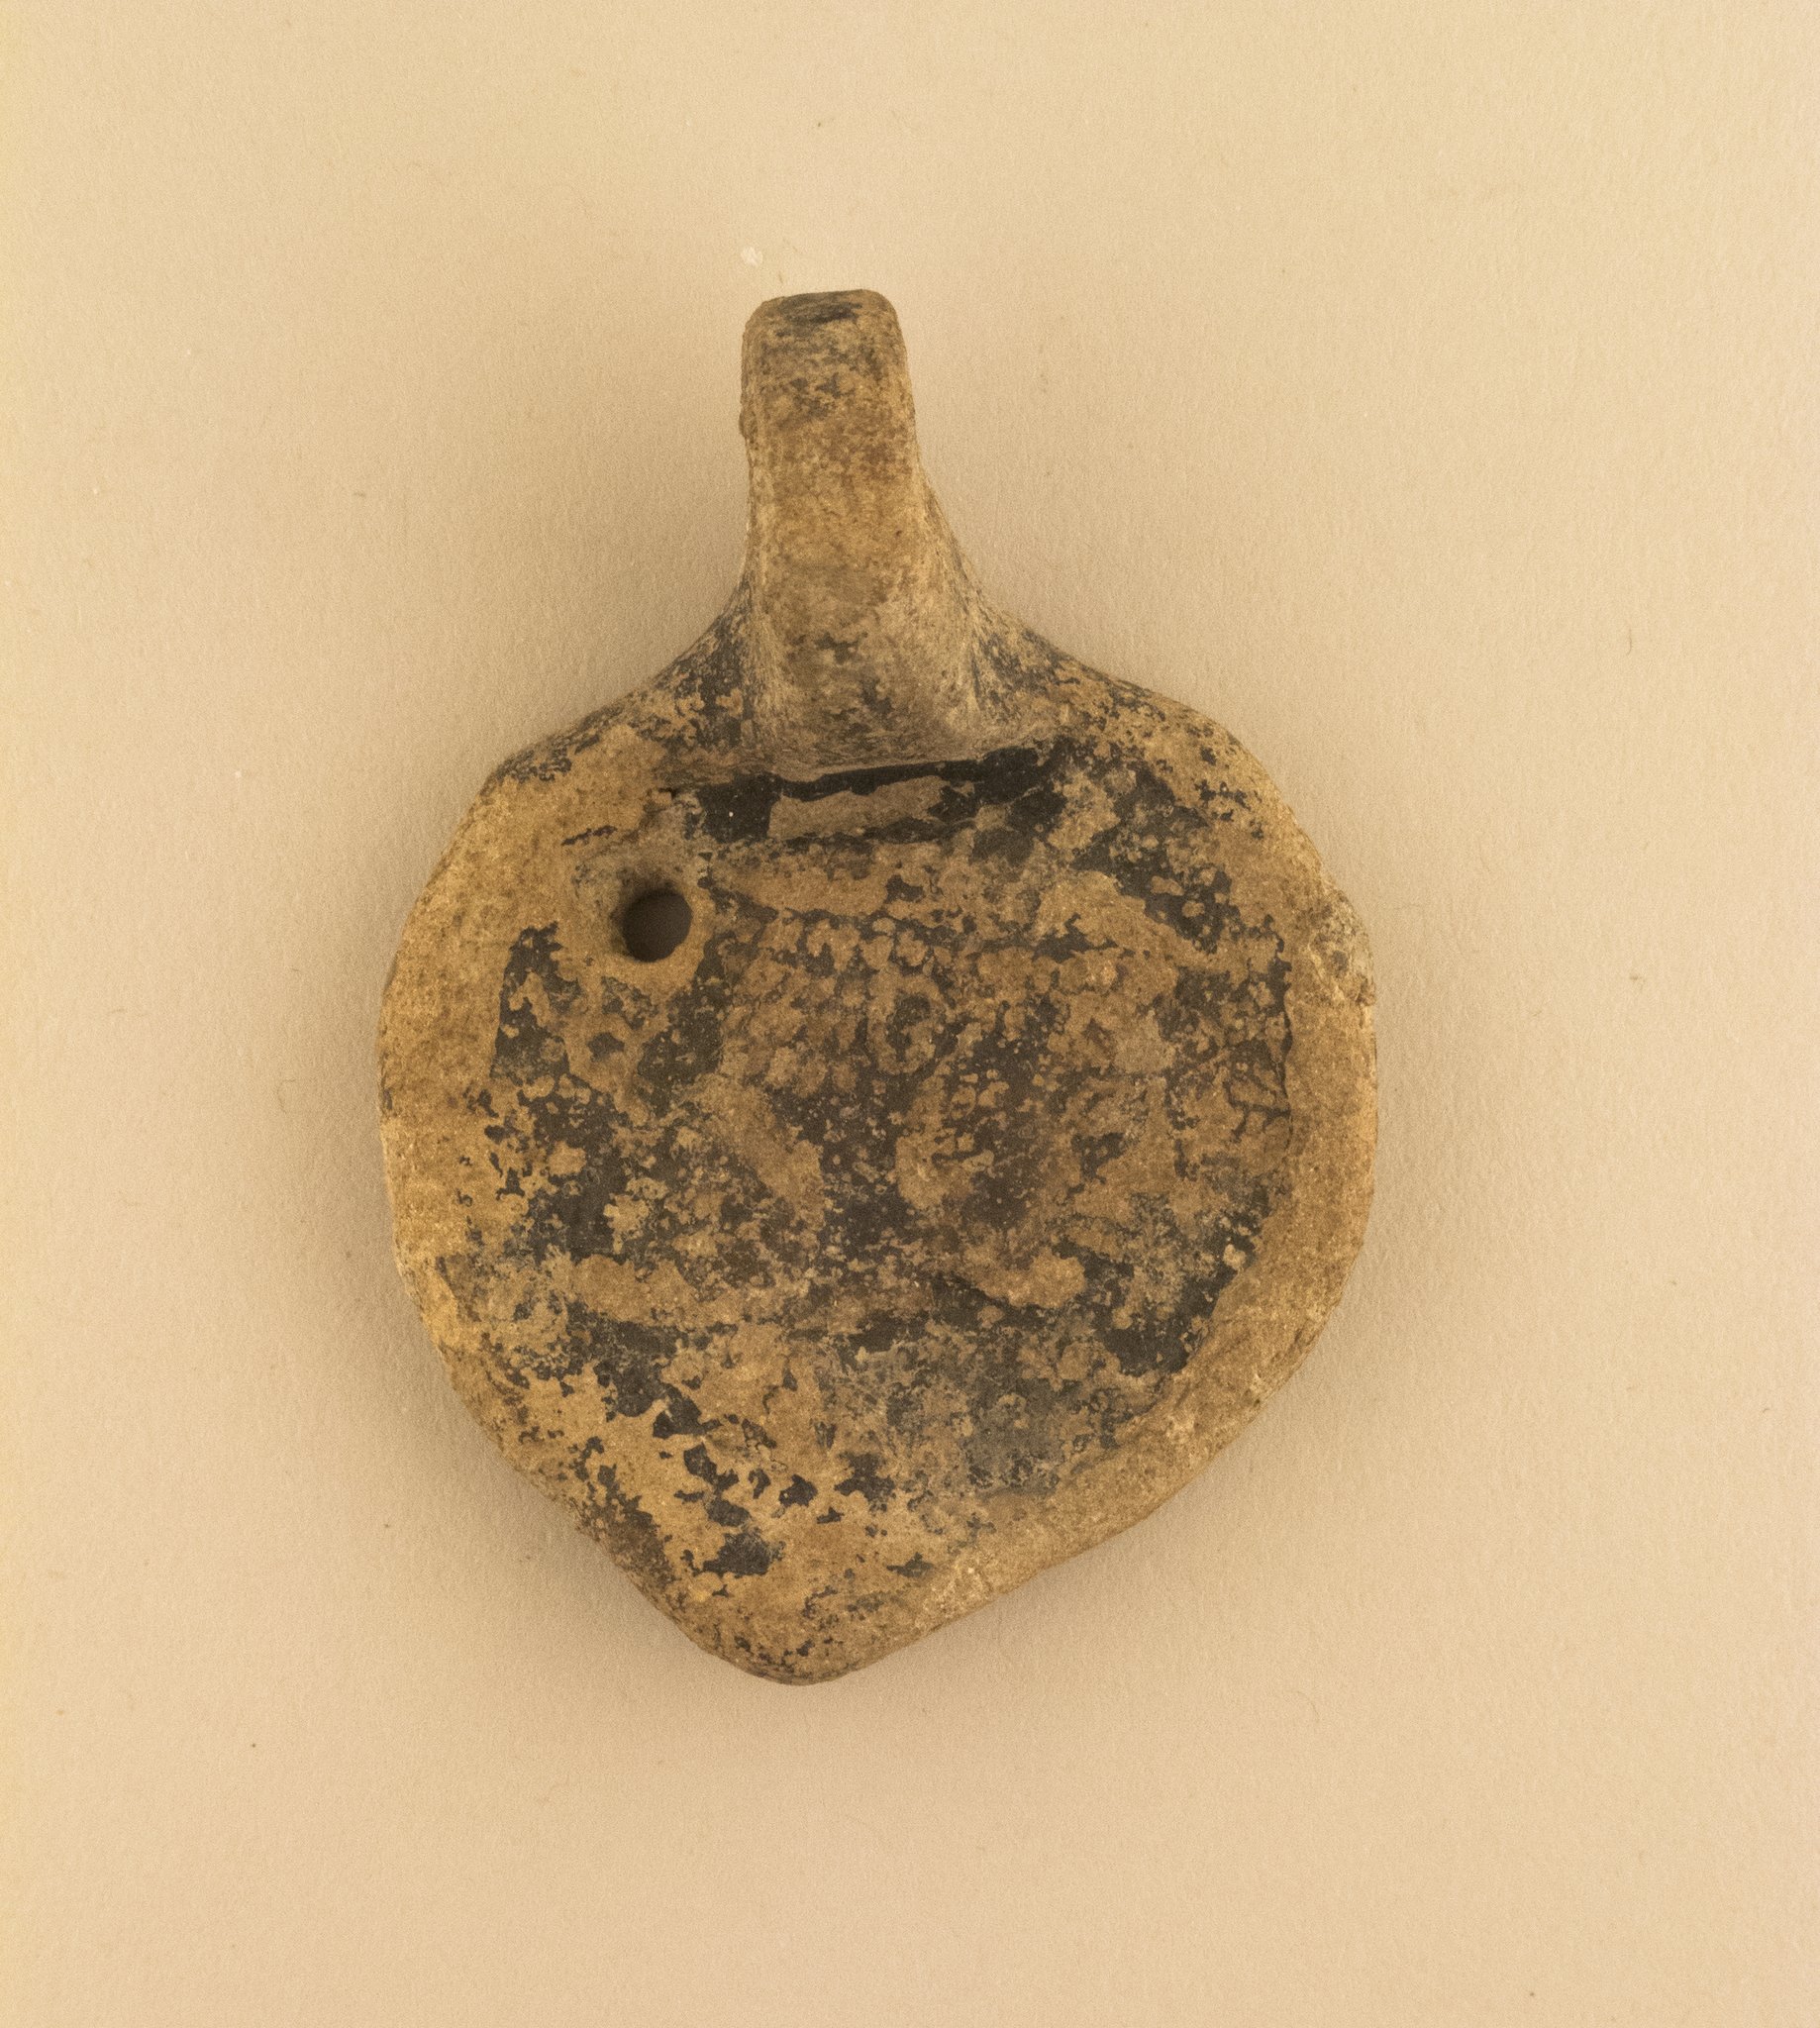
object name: pendant in the form of a lamp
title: Terracotta pendant in the form of a lamp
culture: roman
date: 1-200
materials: terracotta